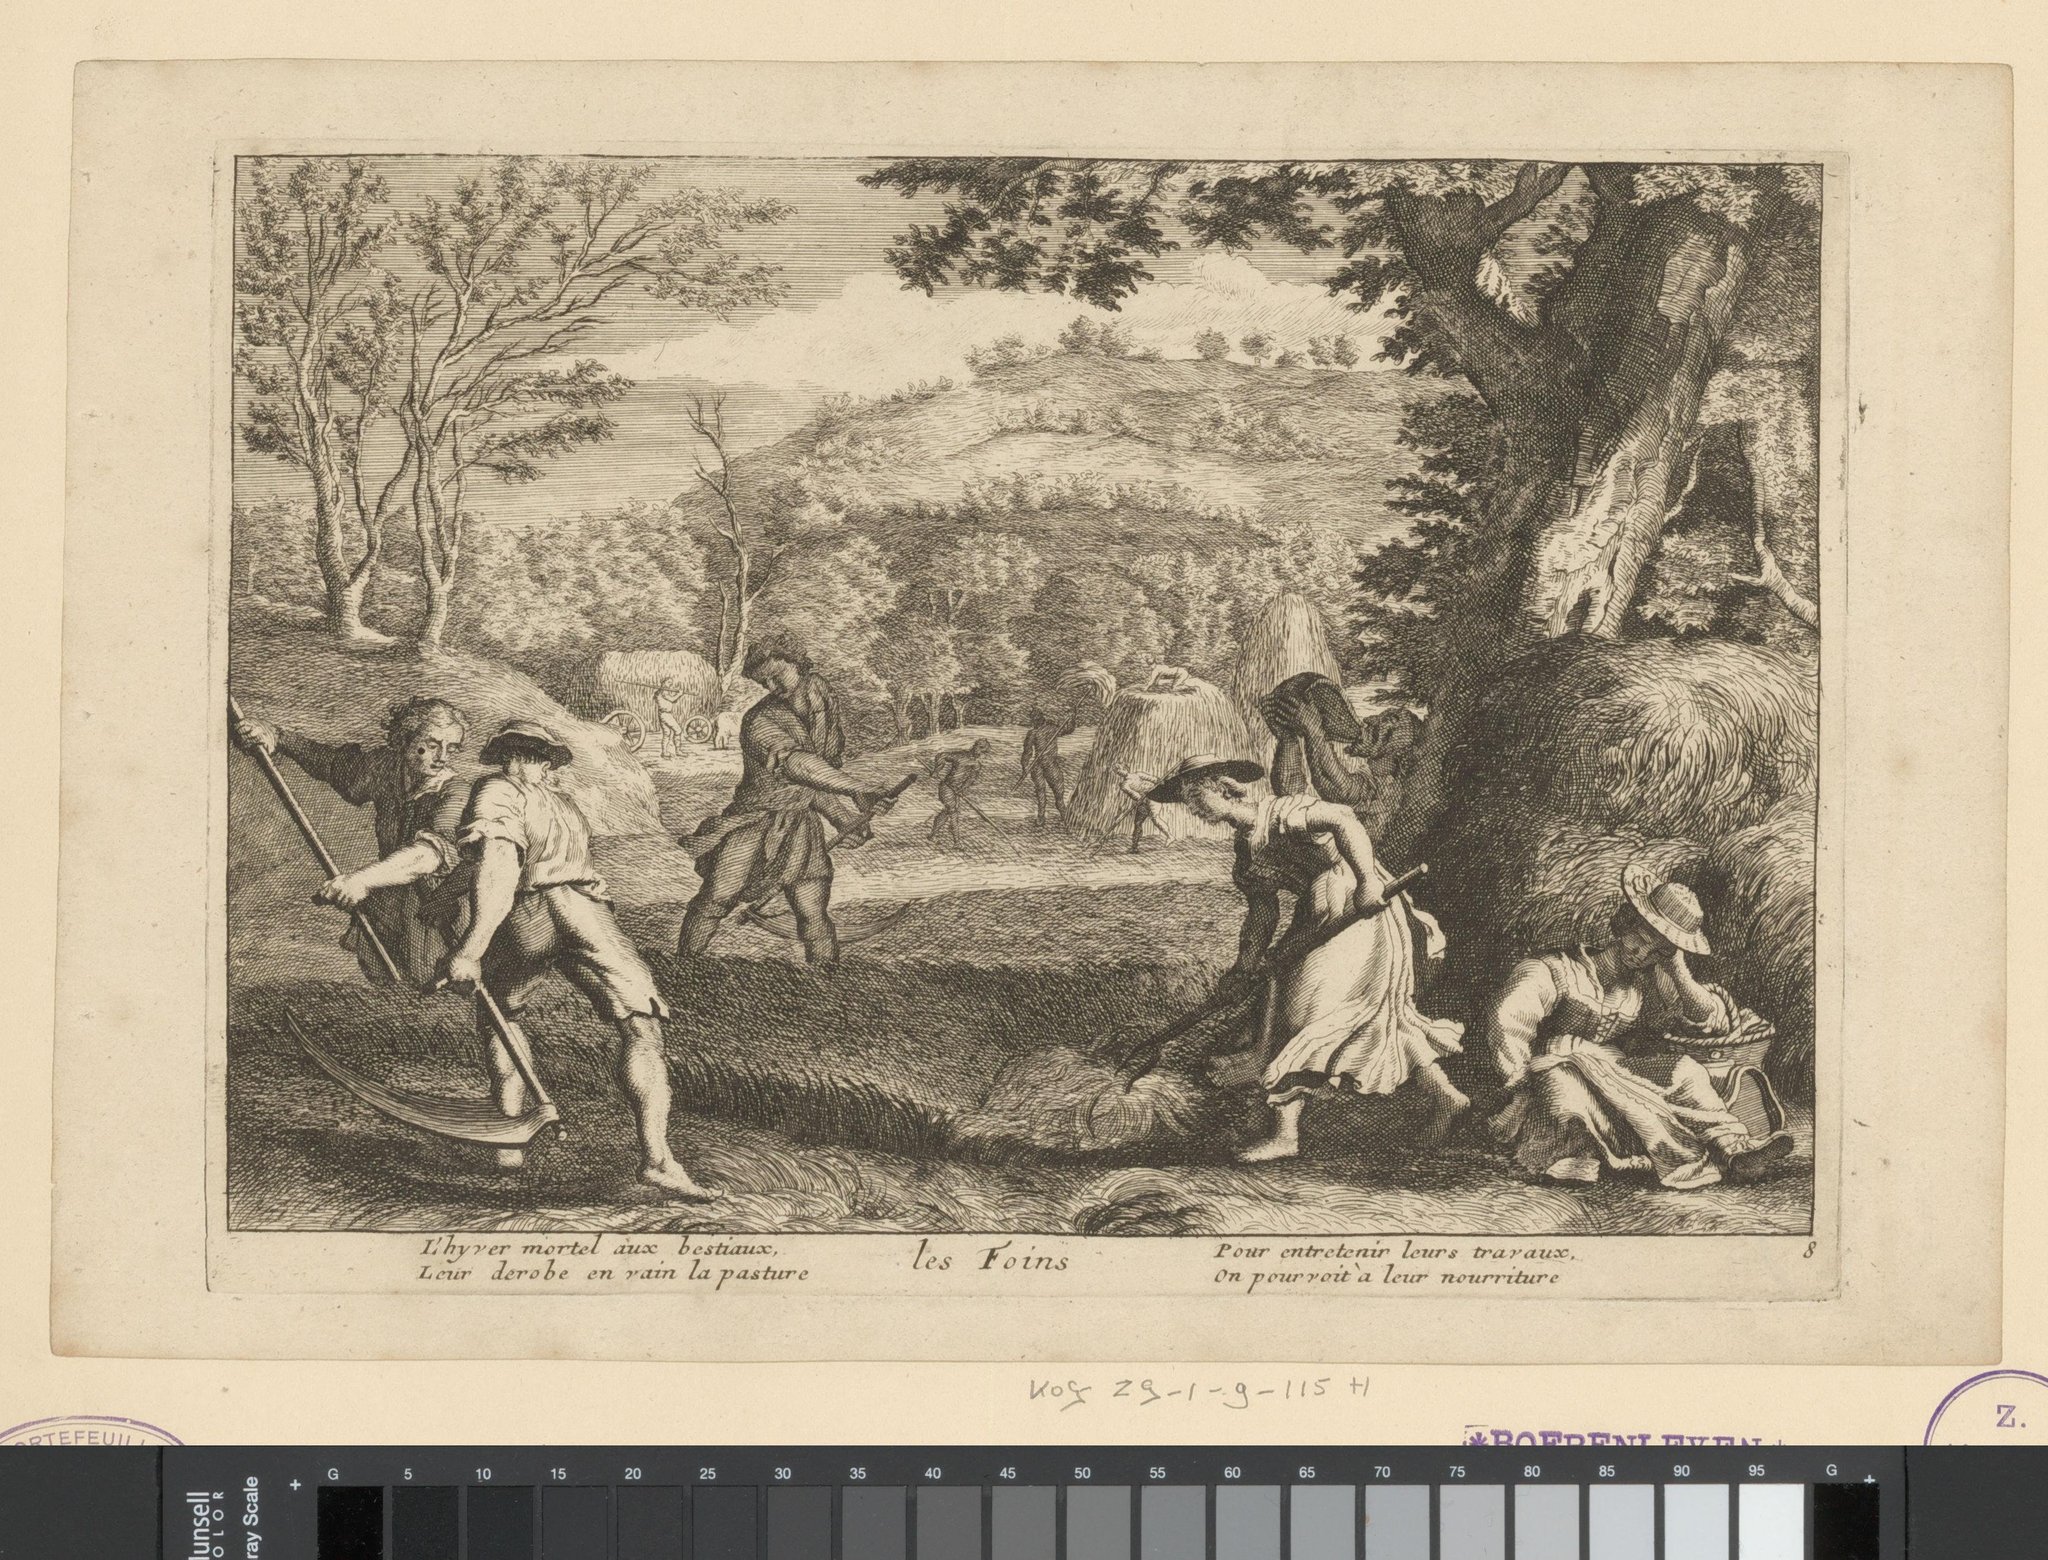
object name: print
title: Landelijke en pastorale scènes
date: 1670-1726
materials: paper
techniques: engraving, etching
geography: amsterdam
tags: agricultural implements: scythe, harvest, hay-stack, reaping, picking, mowing ~ harvest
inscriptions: collector's mark: Lugt 1641, collector's mark: Lugt 1641, stamp:, stamp:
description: Genummerd rechtsonder: 8. Onderwerpsrubrieken binnen de Atlas Zeden en Gewoonten: Handel, nijverheid en verkeer, Boerenleven.